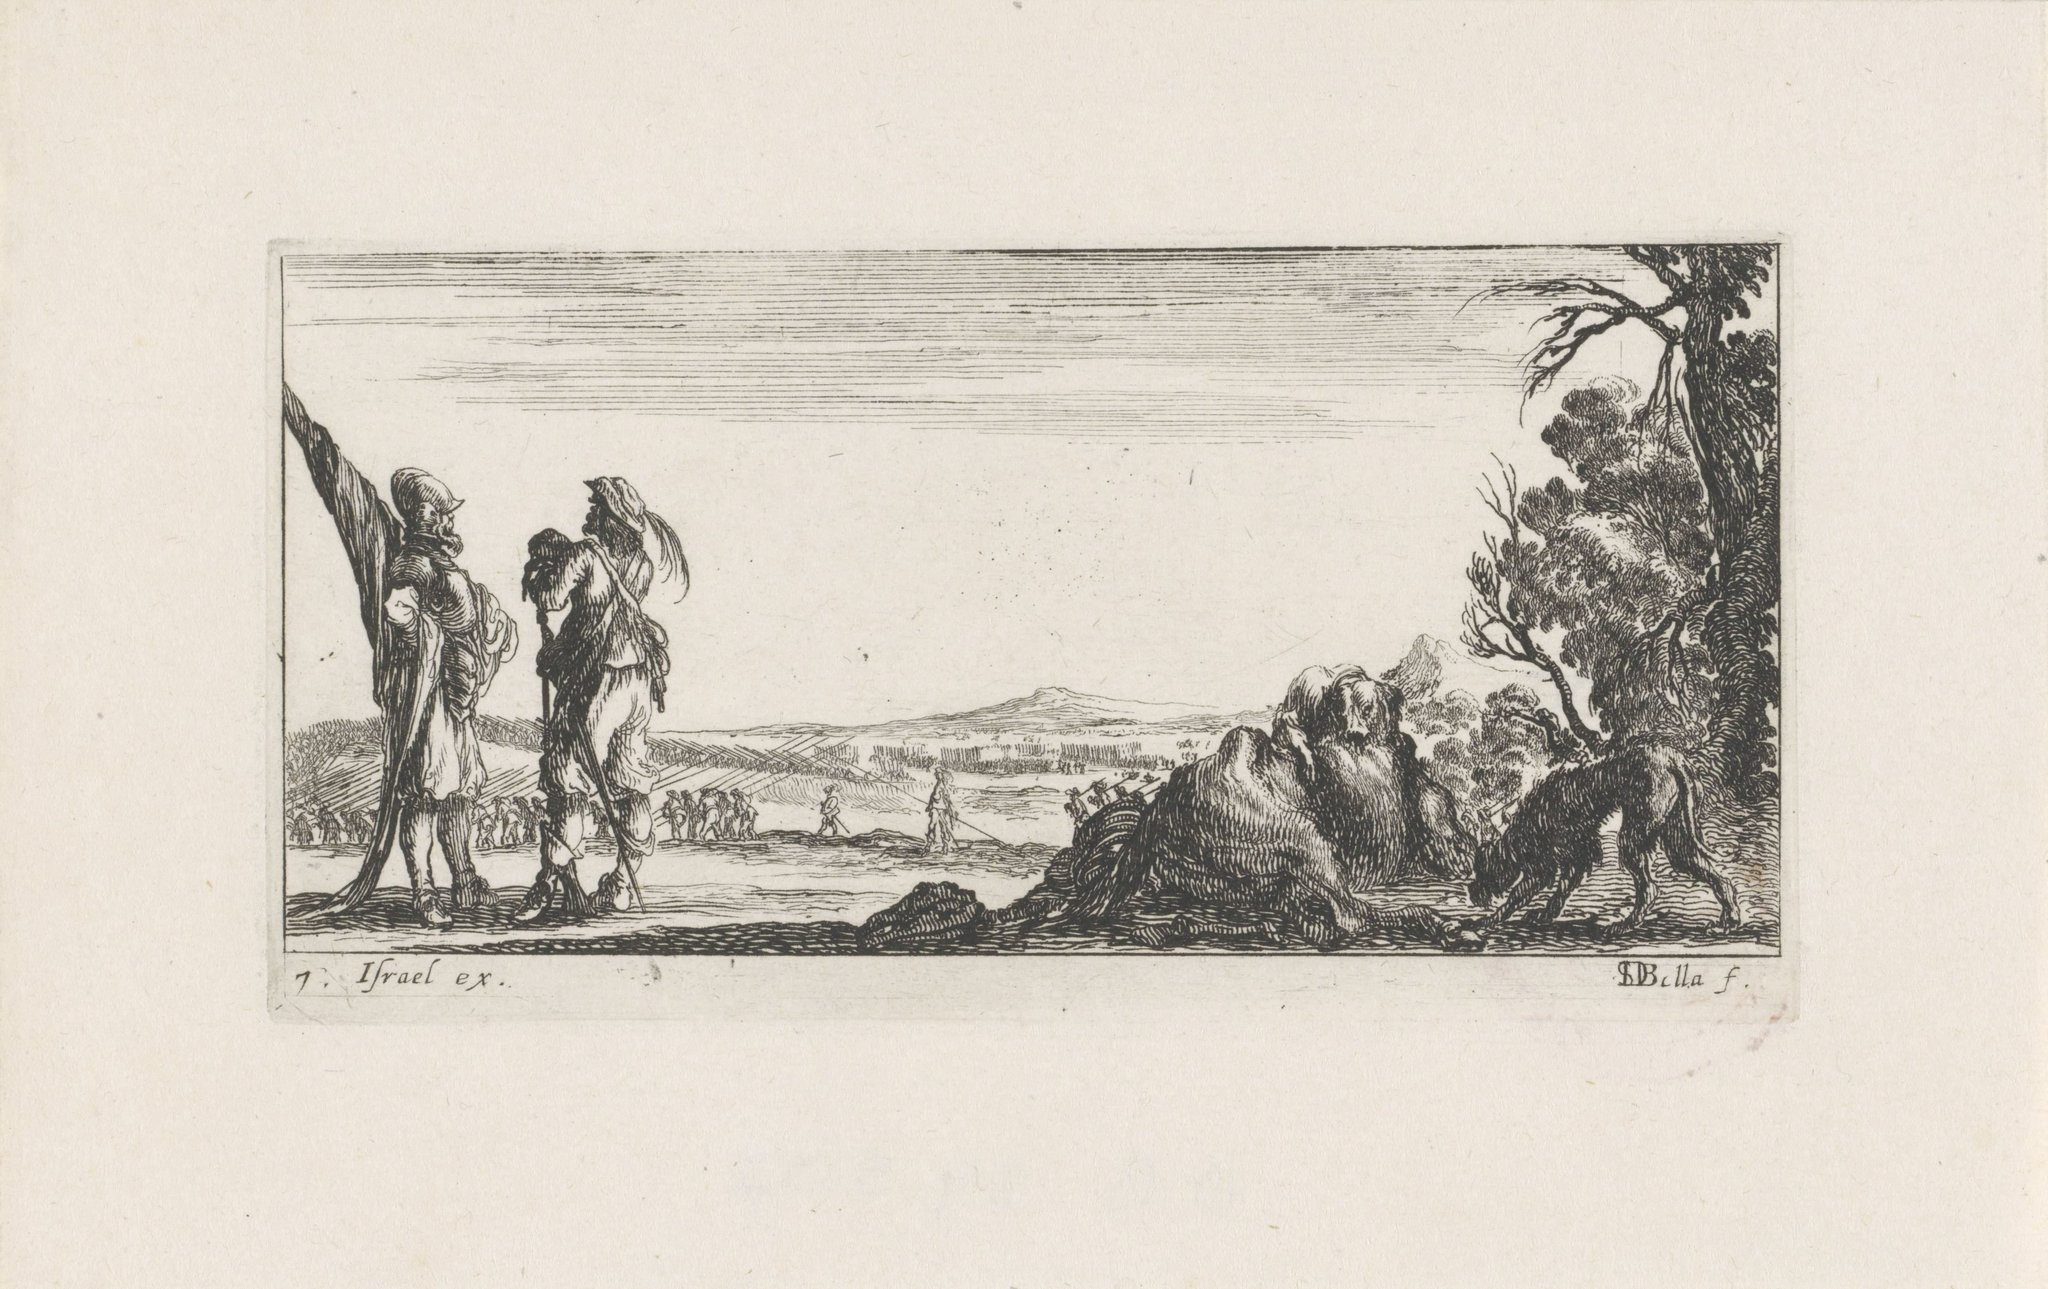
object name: print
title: Troepen, wapens en aanvallen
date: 1620-1664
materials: paper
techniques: etching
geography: france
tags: the soldier; the soldier's life, horse, conversation, dialogue; conversation piece, horse (+ dying animal; death of animal; dead animal)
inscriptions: collector's mark: Lugt 240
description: Links staan twee soldaten met elkaar te praten, een draagt een vaandel. Op de achtergrond marcheren soldaten met speren. Rechtsvoor ligt een gesneuveld paard en staat een hond.